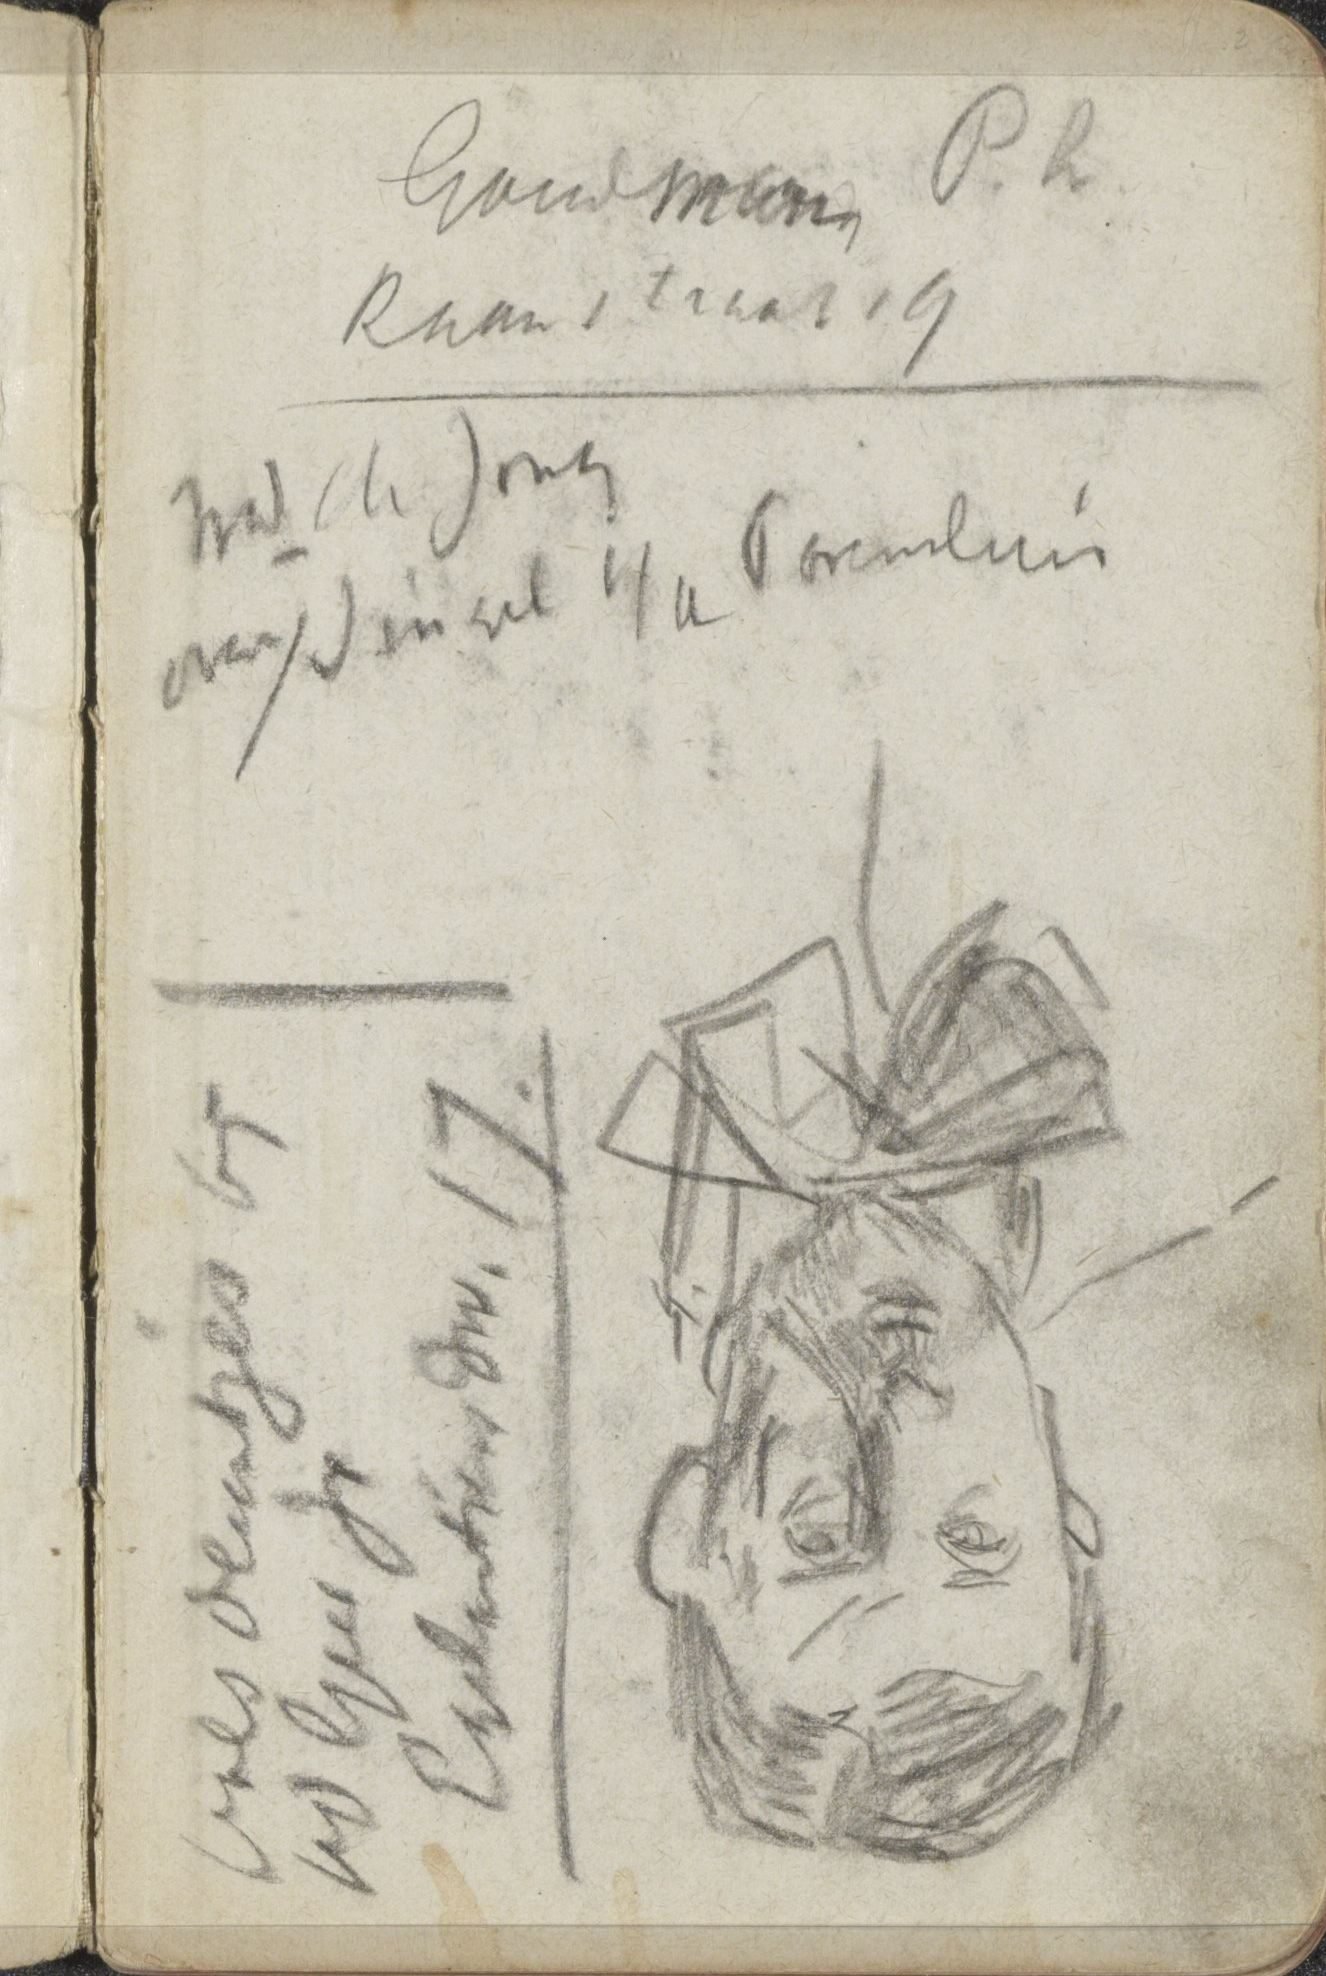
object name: sketchbook leaf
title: Portret van een onbekende man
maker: george hendrik breitner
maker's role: draughtsman, painter, print maker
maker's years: 1857-1923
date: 1893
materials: chalk, paper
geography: amsterdam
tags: anonymous historical person portrayed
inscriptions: annotation: ‘Gaudmann P.H./ Raamstraat 19/ [...] de Jong/ [...] Singel b/d Torensluis/ [...] Egelantiersdw. 17.’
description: Pagina 2, vrij schutblad, uit een schetsboek met 38 bladen.